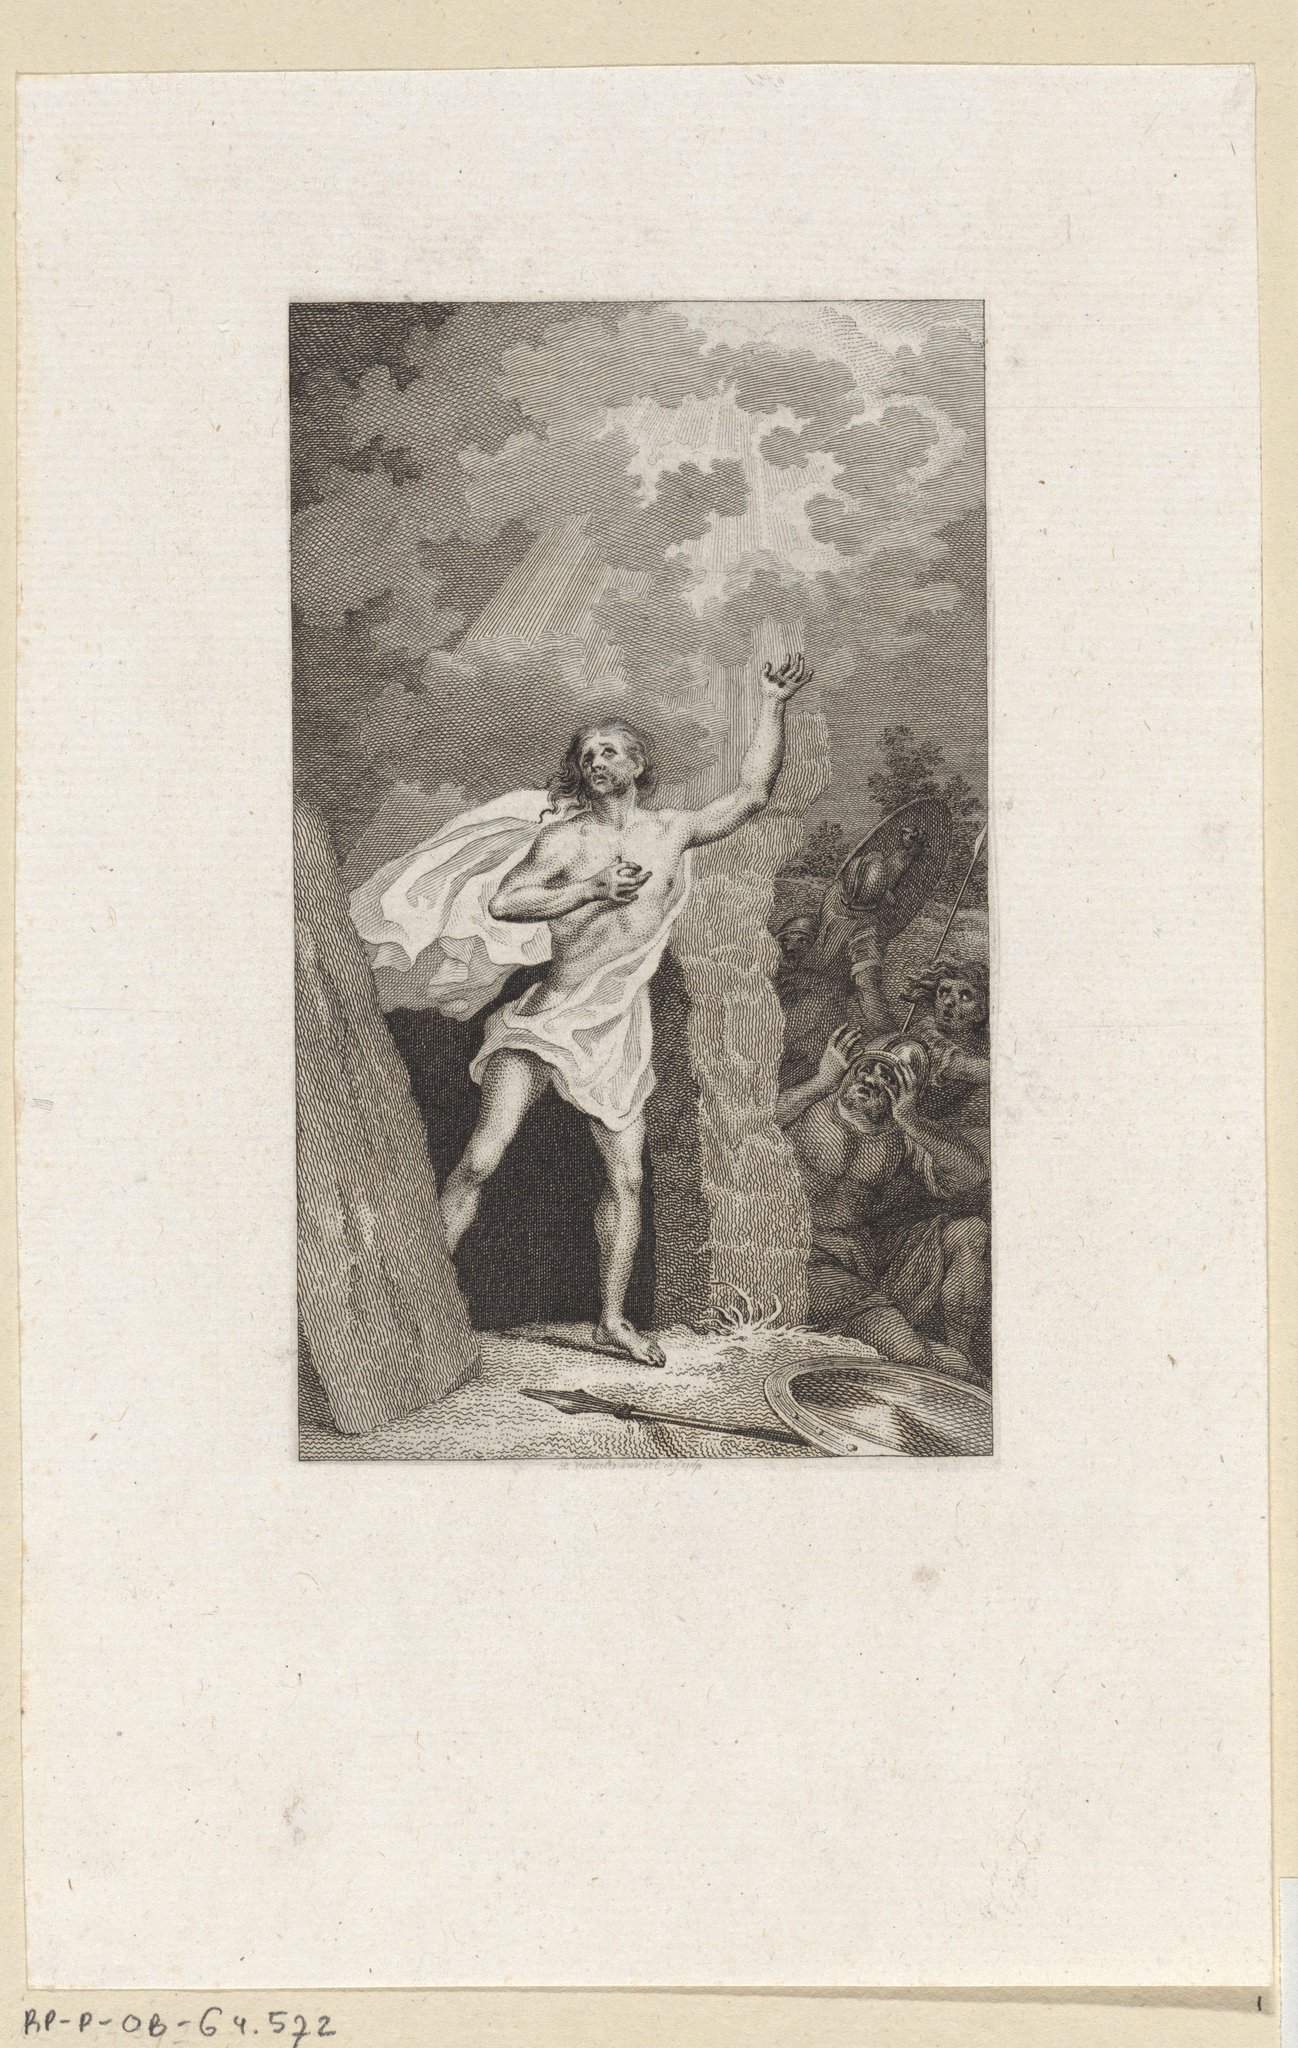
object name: print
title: Opstanding van Christus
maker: reinier vinkeles (i)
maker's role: draughtsman, print maker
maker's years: 1741-1816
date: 1799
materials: paper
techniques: engraving, etching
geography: amsterdam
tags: resurrection of christ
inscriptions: collector's mark: Lugt 240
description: Proefdruk van illustratie in: Hamelsveld, Ysbrand van. Algemeene kerkelijke geschiedenis, der Christenen, deel 1. Haarlem: François Bohn, 1799, p. 133.